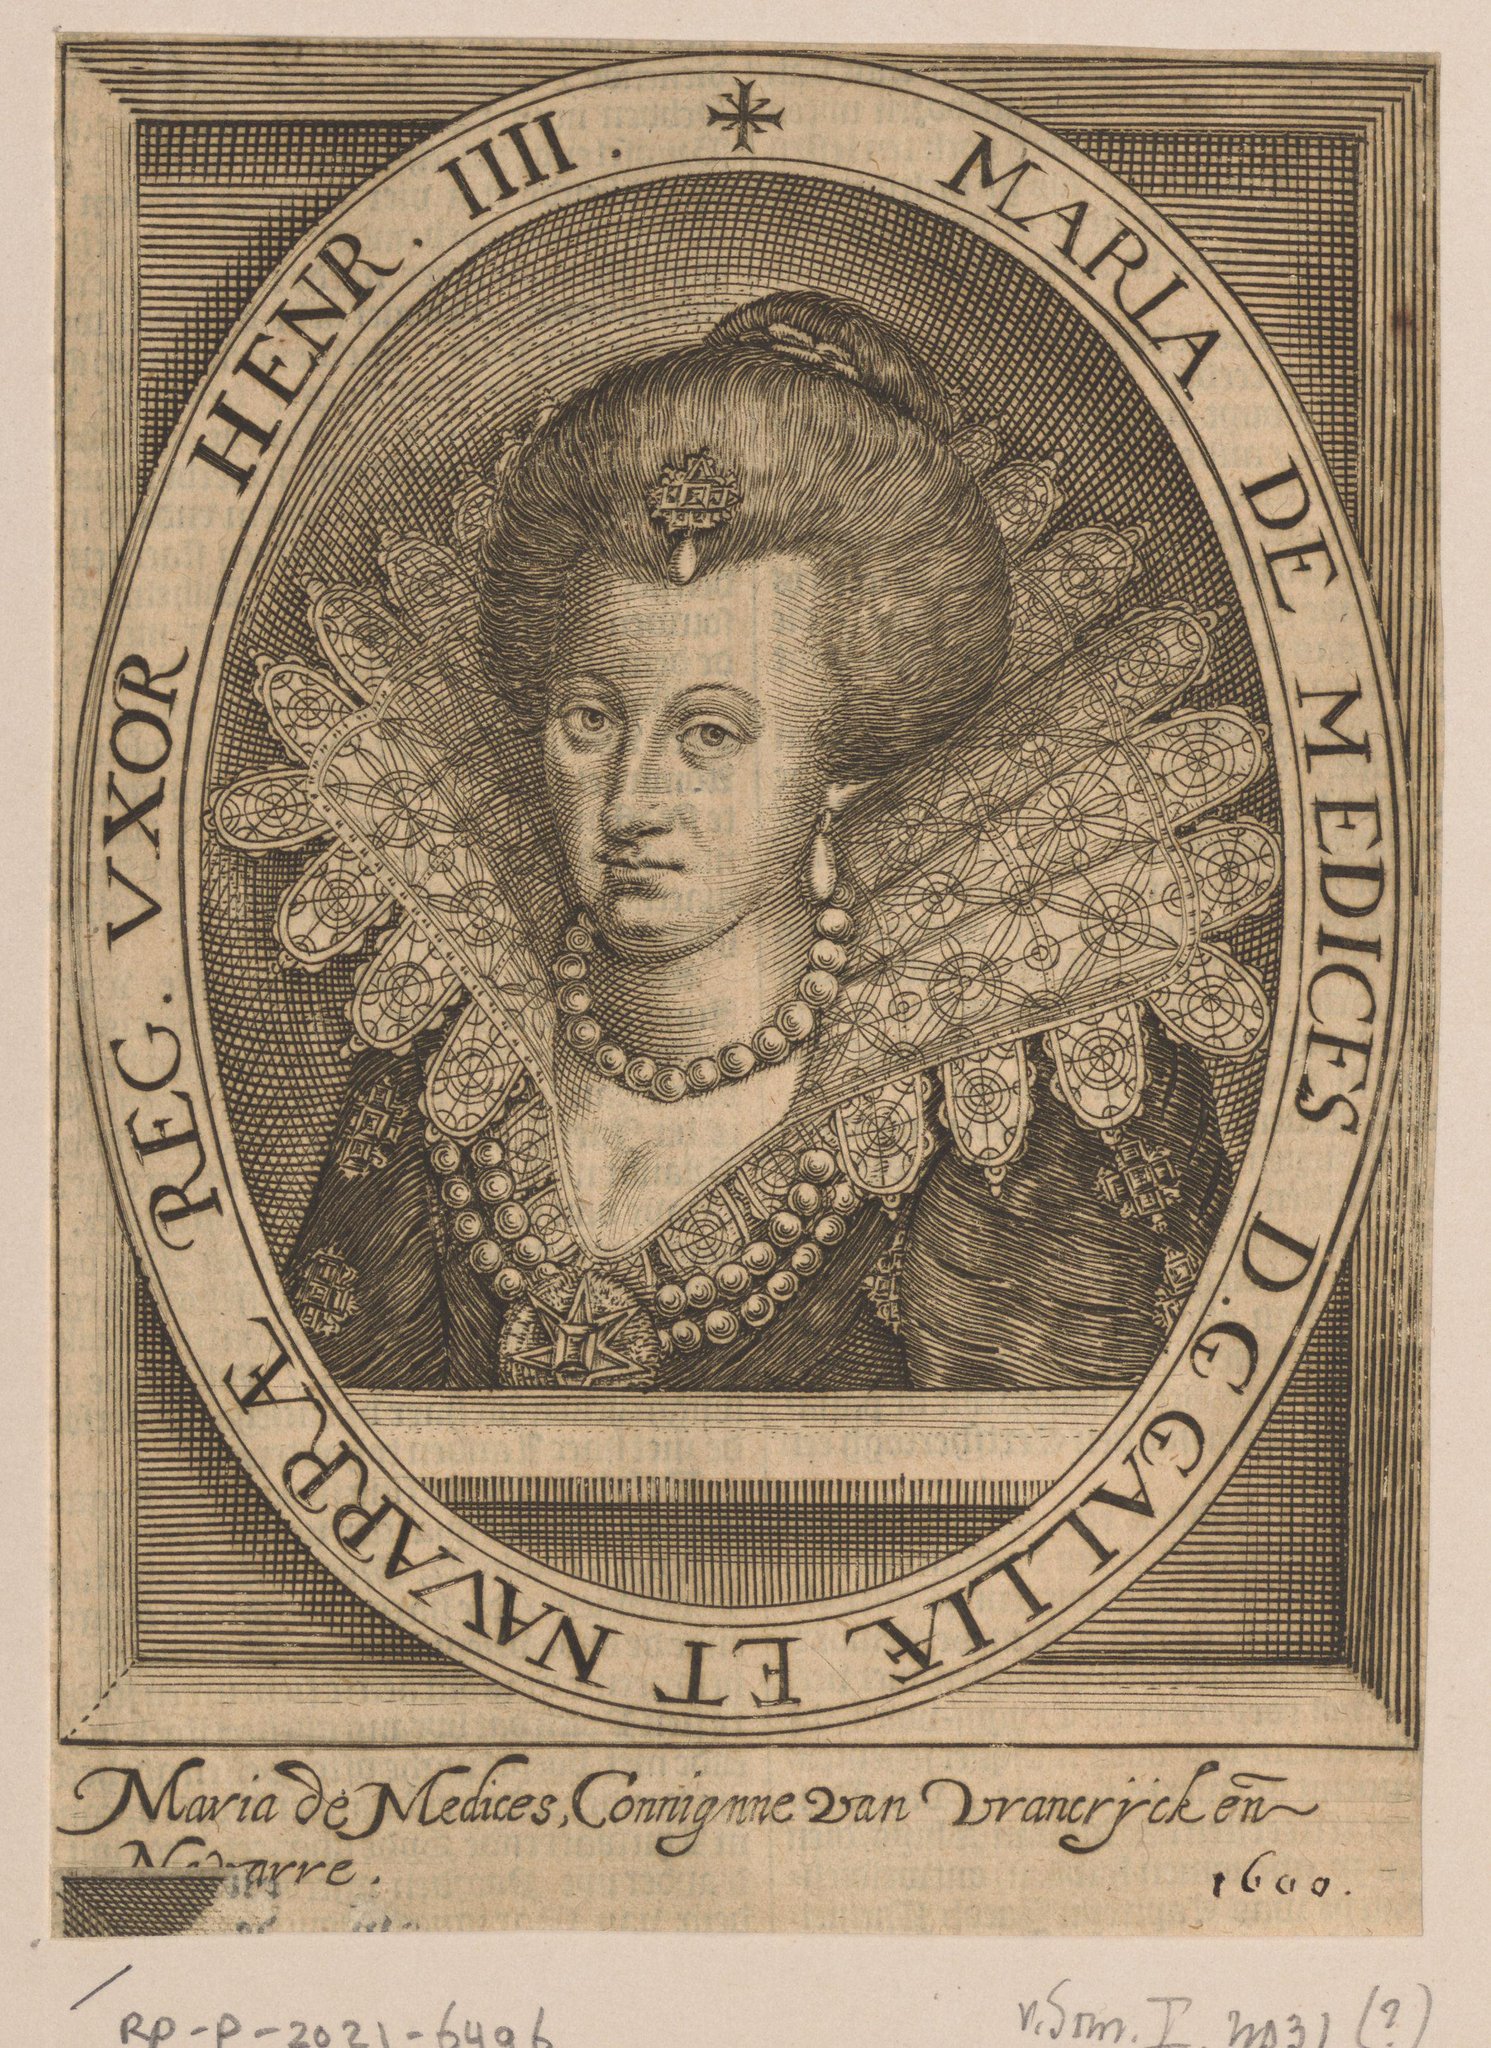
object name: print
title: Portret van Maria de' Medici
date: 1614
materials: paper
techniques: engraving, letterpress printing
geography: the hague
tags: cologne, print maker, maria de' medici, historical persons - bb - woman, ornament ~ medallion, queen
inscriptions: inscription: ‘1600’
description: Prent uit: Meteren, Emanuel van. Historie der Neder-landscher ende haerder Na-buren Oorlogen ende geschiedenissen (...). Den Haag: Hillebrant Jacobsz. van Wouw, 1614. De prent is mogelijk ook gebruikt in andere edities van dit werk.